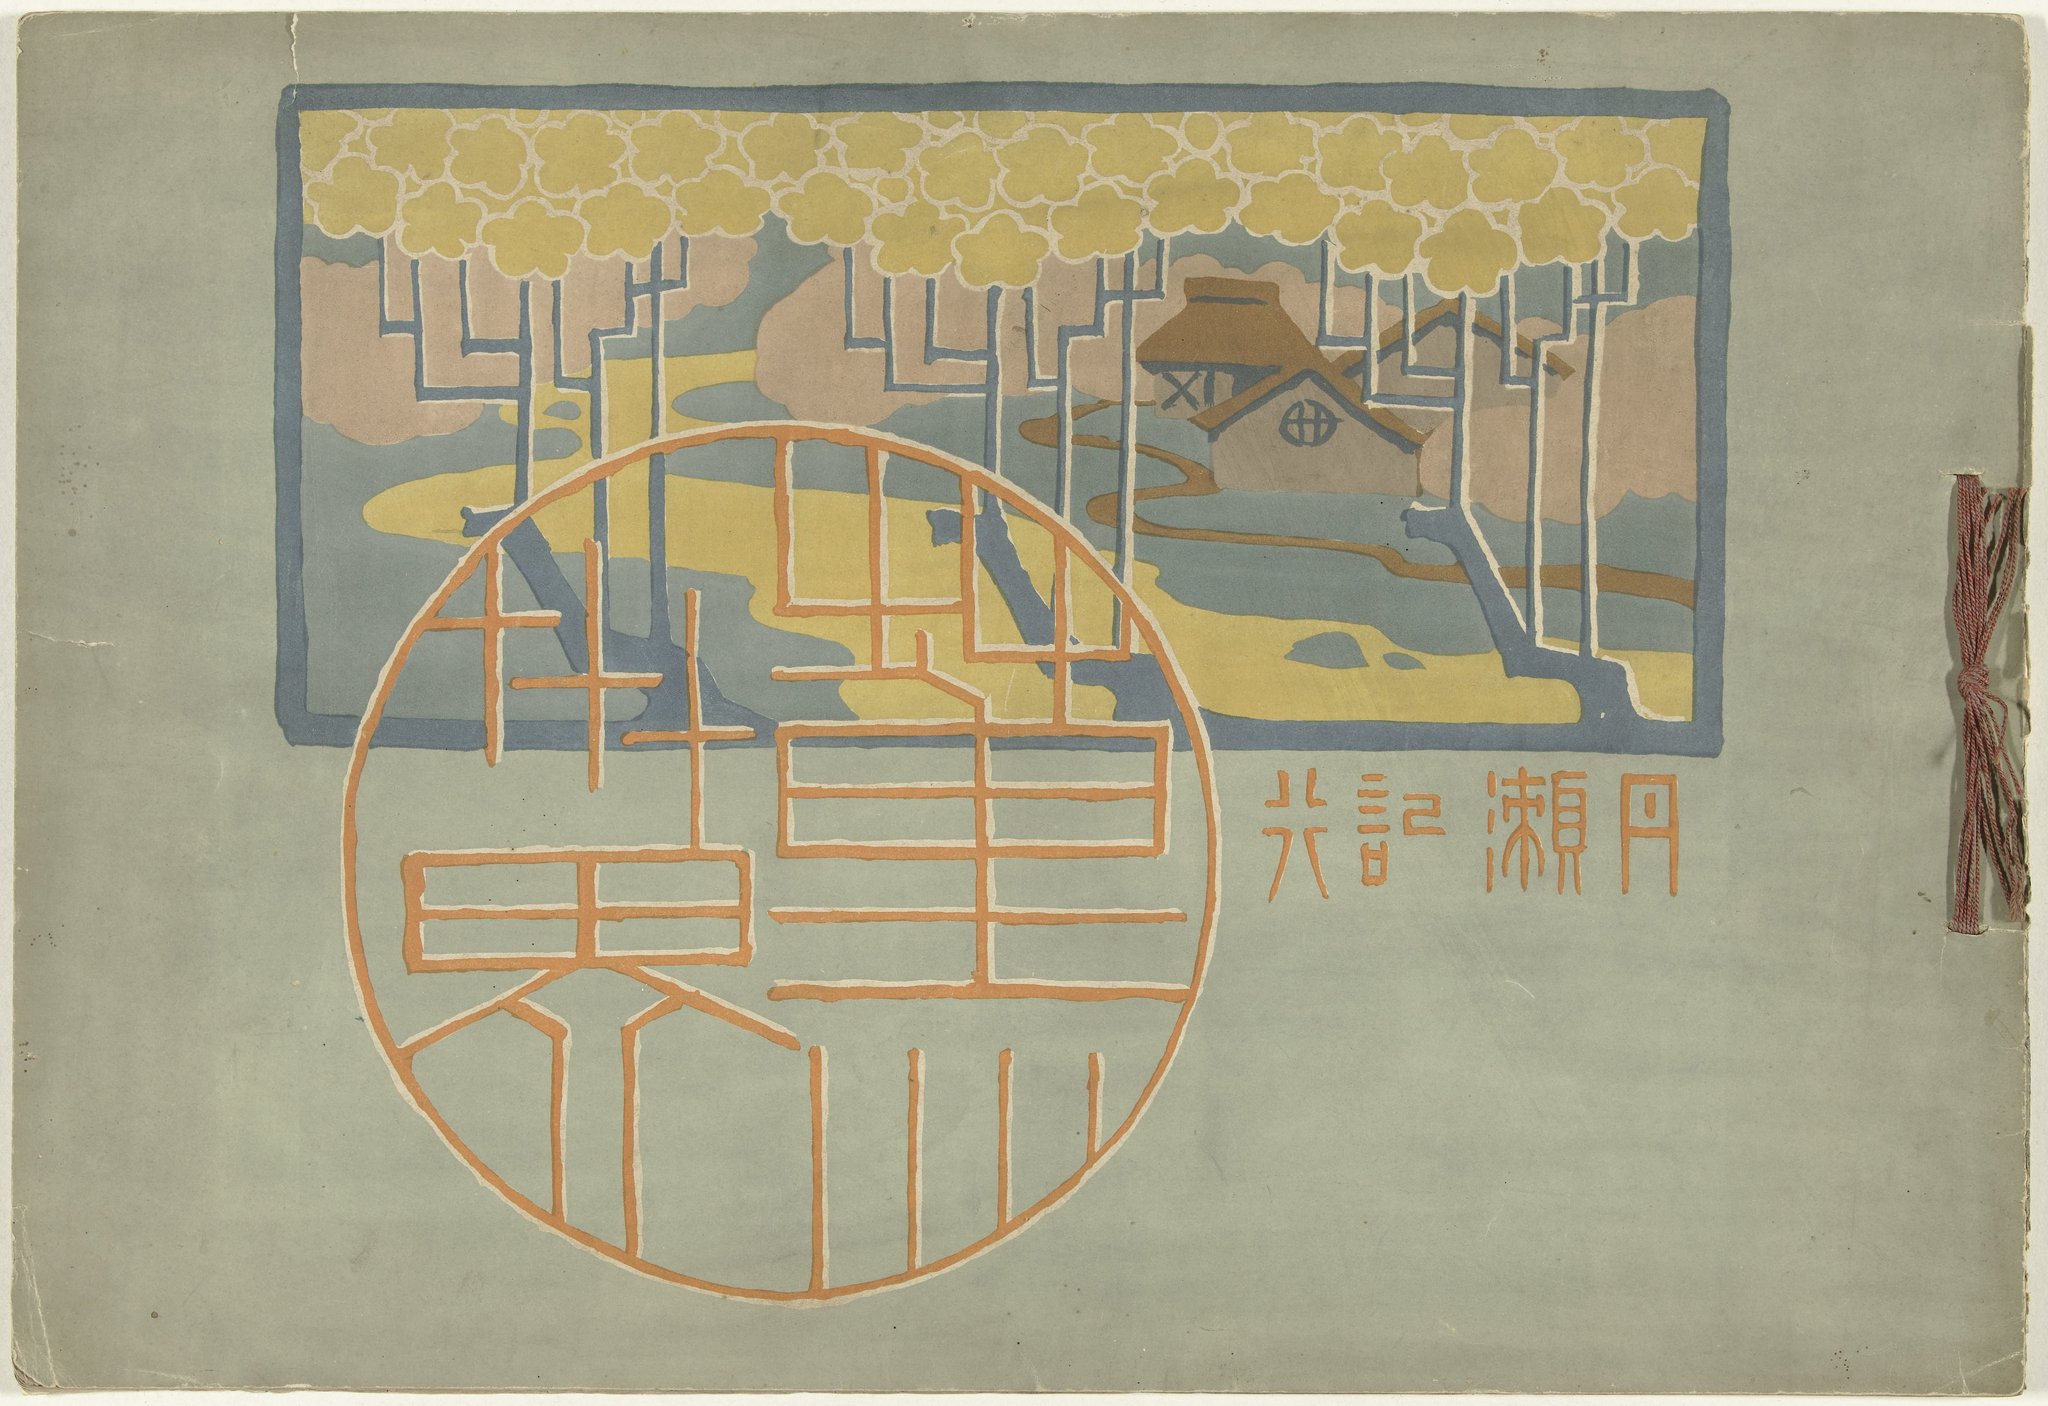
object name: book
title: Kaoru sekai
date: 1905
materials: paper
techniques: woodcut, letterpress printing, lithograph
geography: japan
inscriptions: date